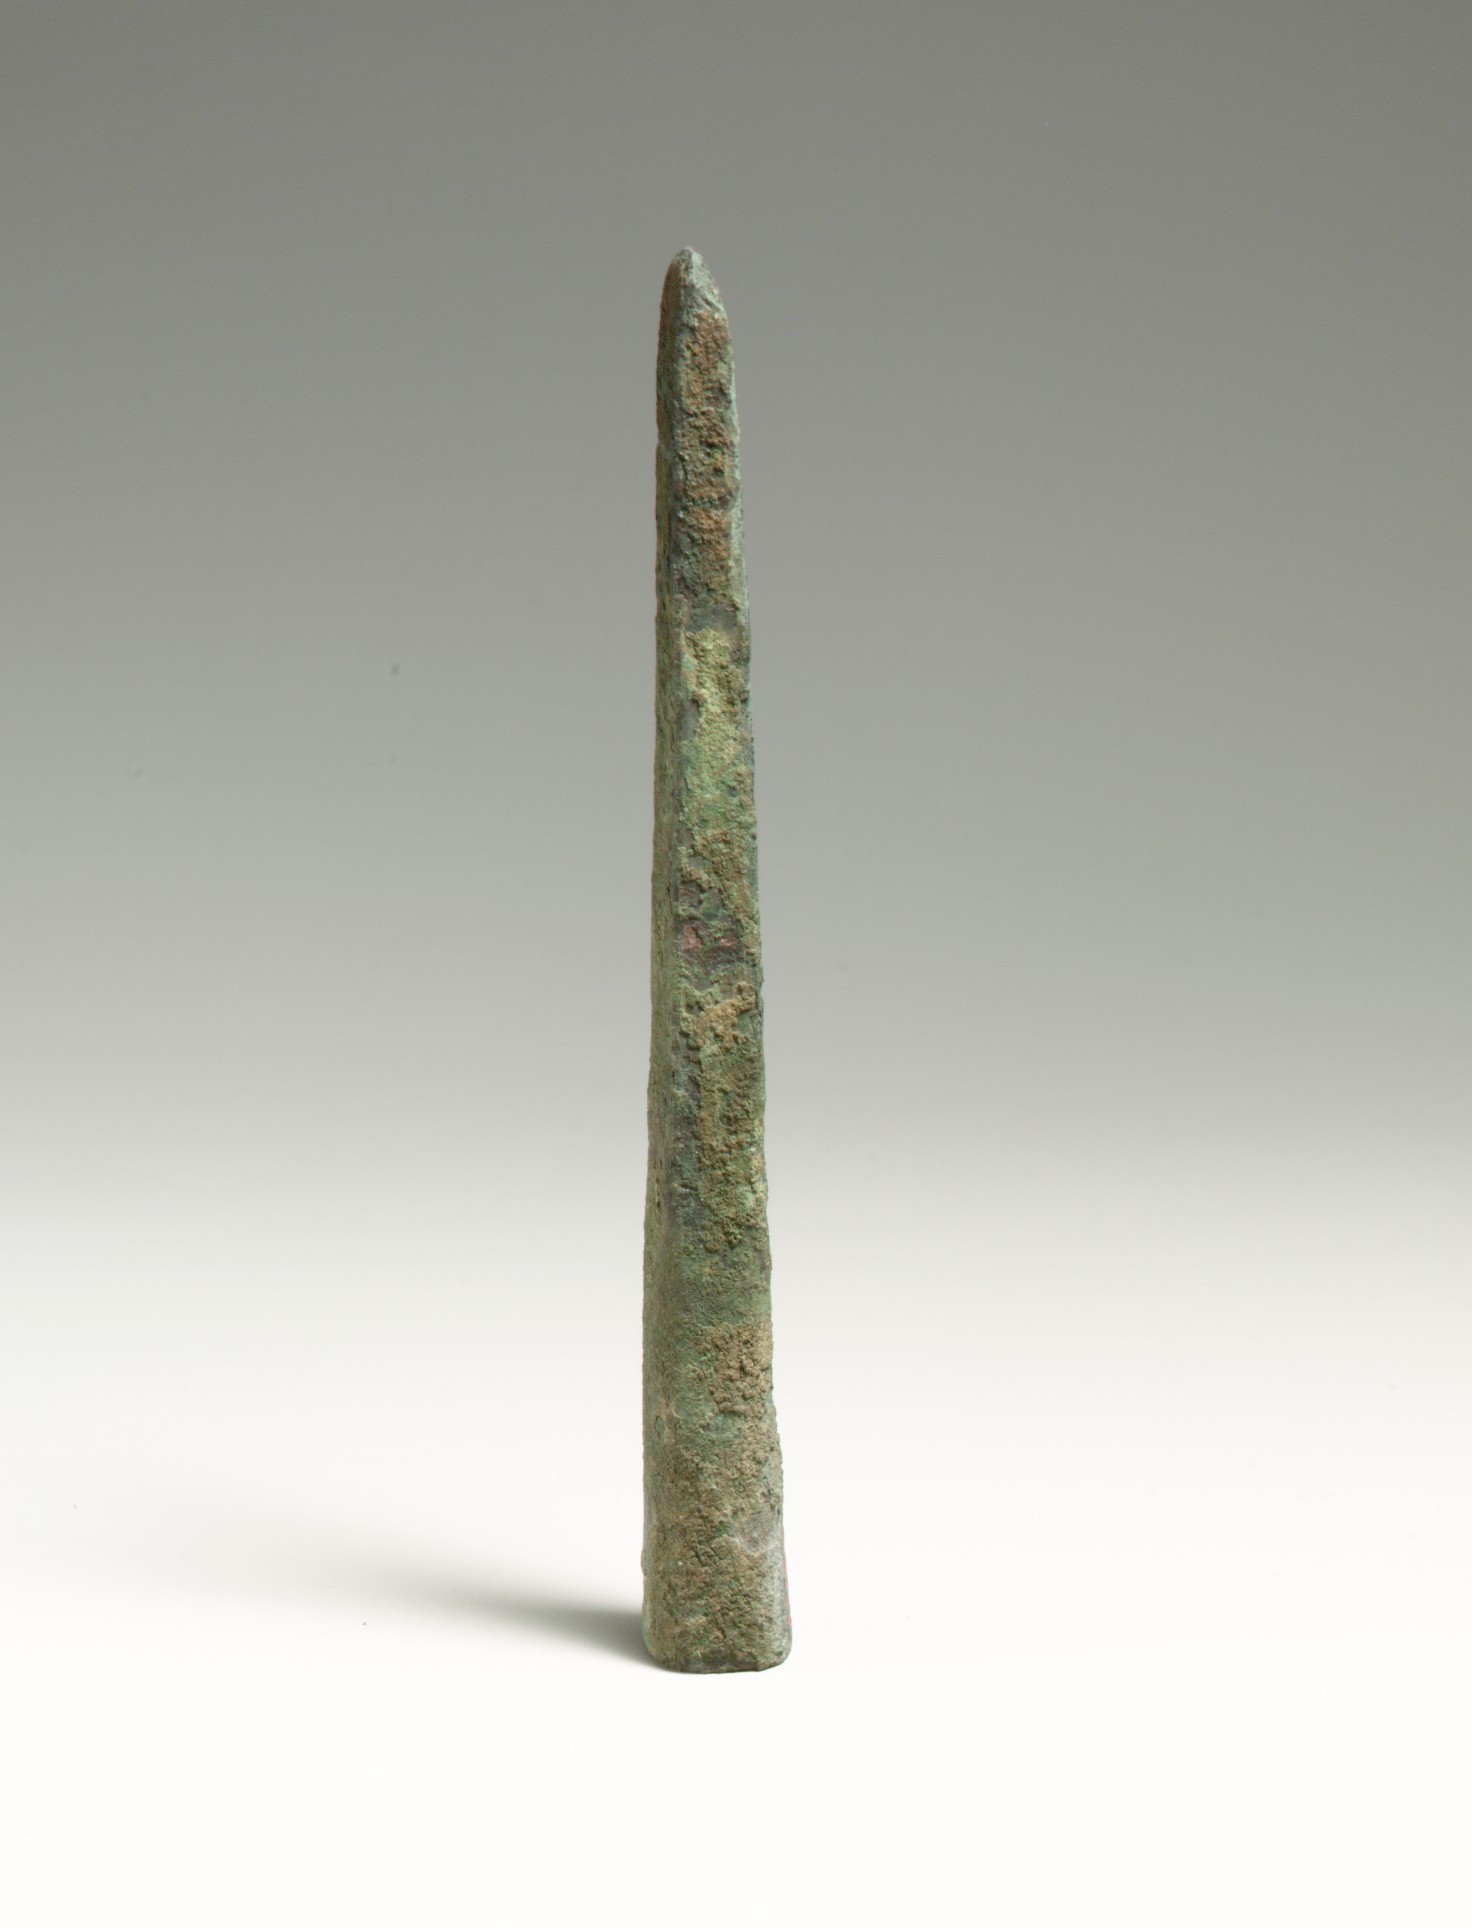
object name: chisel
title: Chisel ?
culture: cypriot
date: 1050-1000 BCE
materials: bronze